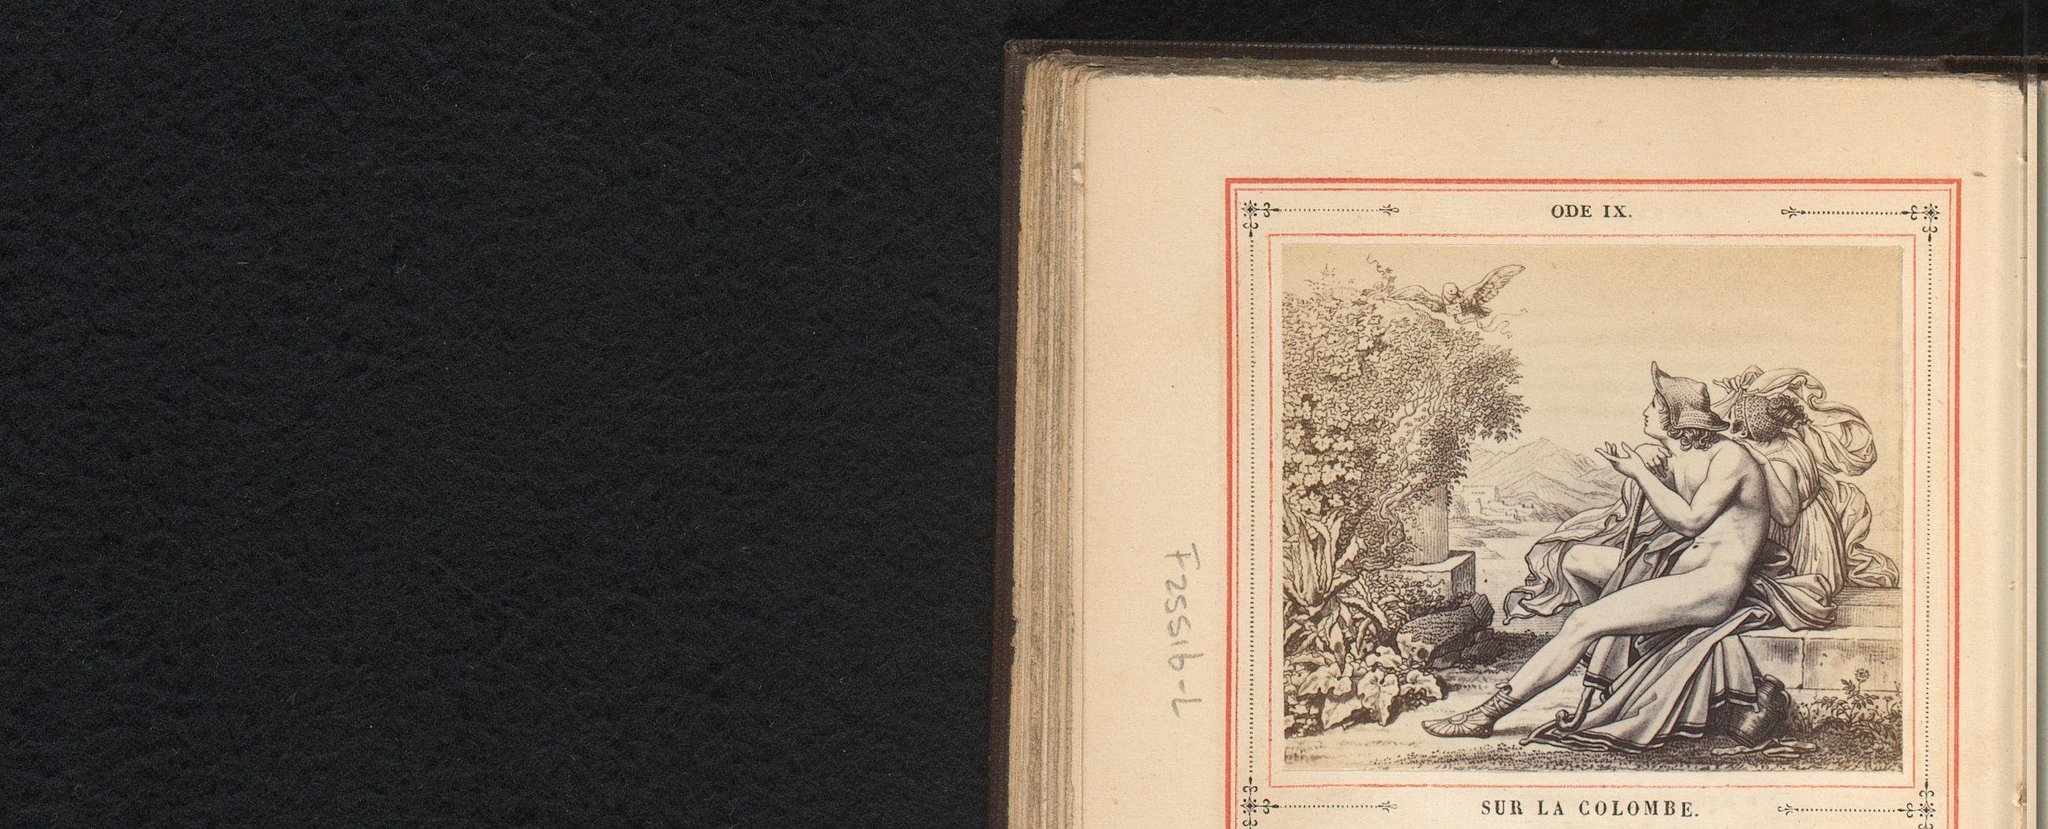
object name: page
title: Fotoreproductie van een tekening van Girodet, goden met een duif, illustratie bij Apothéose d'Anacréon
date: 1859-1864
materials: paper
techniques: albumen print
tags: gods ~ classical mythology